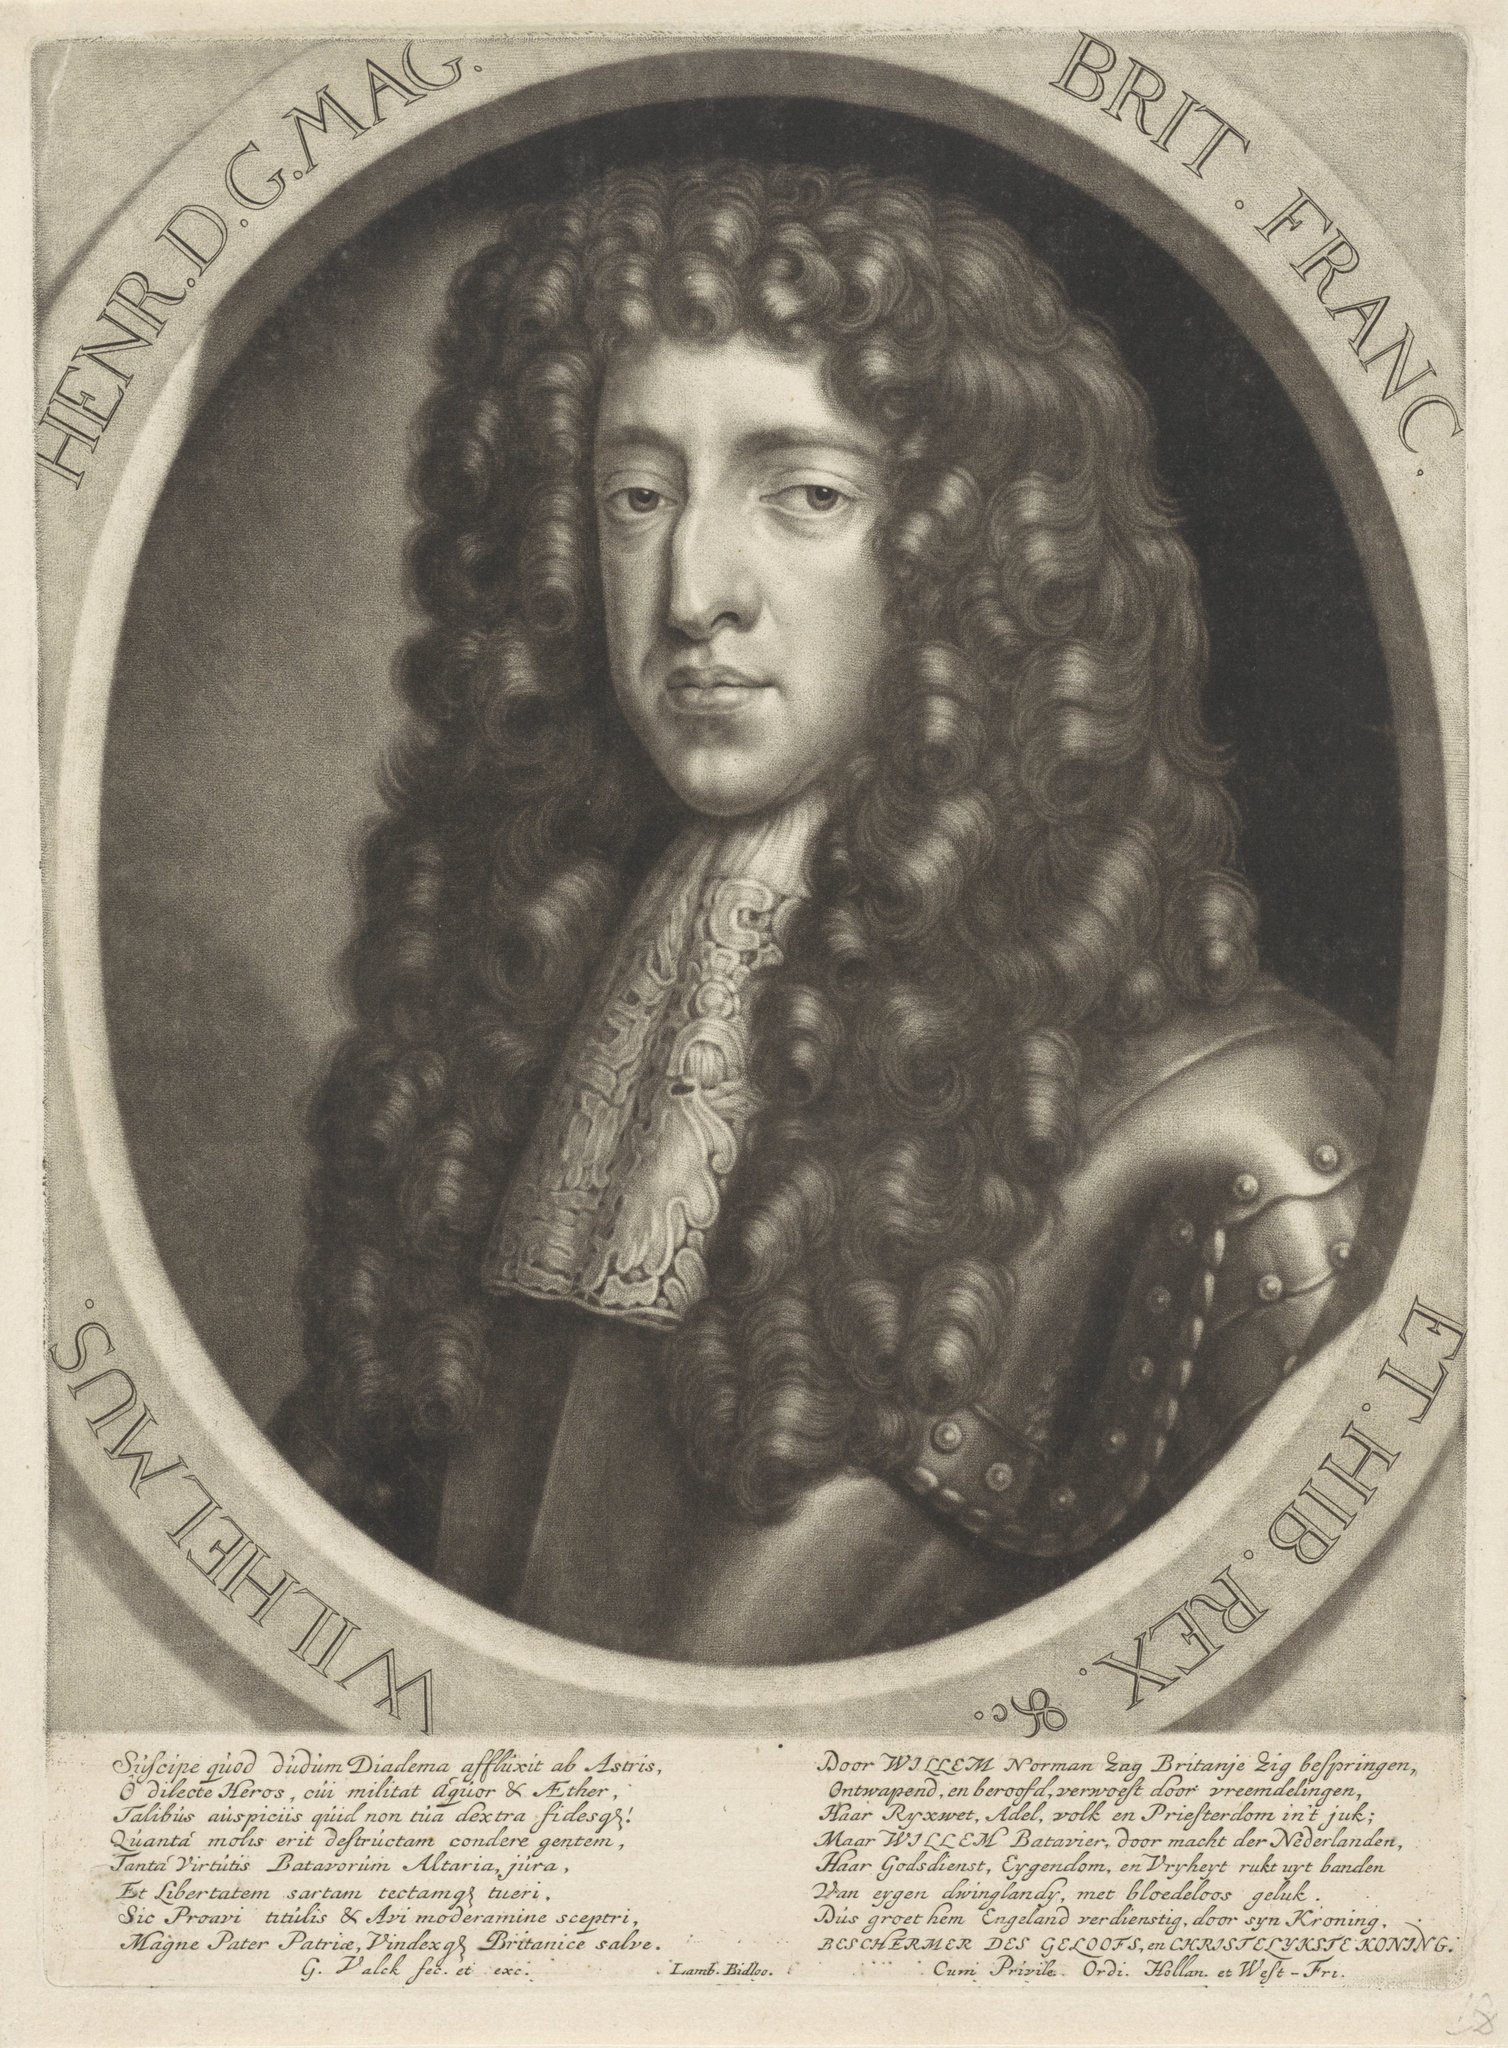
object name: print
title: Portret van stadhouder Willem III, koning van Engeland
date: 1689-1726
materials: paper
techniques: mezzotint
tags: the hague, william iii (prince of orange and king of england, scotland, and ireland), armour, wig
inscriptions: collector's mark: Lugt 2228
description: Willem III, prins van Oranje-Nassau en sinds 1689 koning van Engeland, in harnas. In de marge een lofdicht over zijn kroning in Engeland.